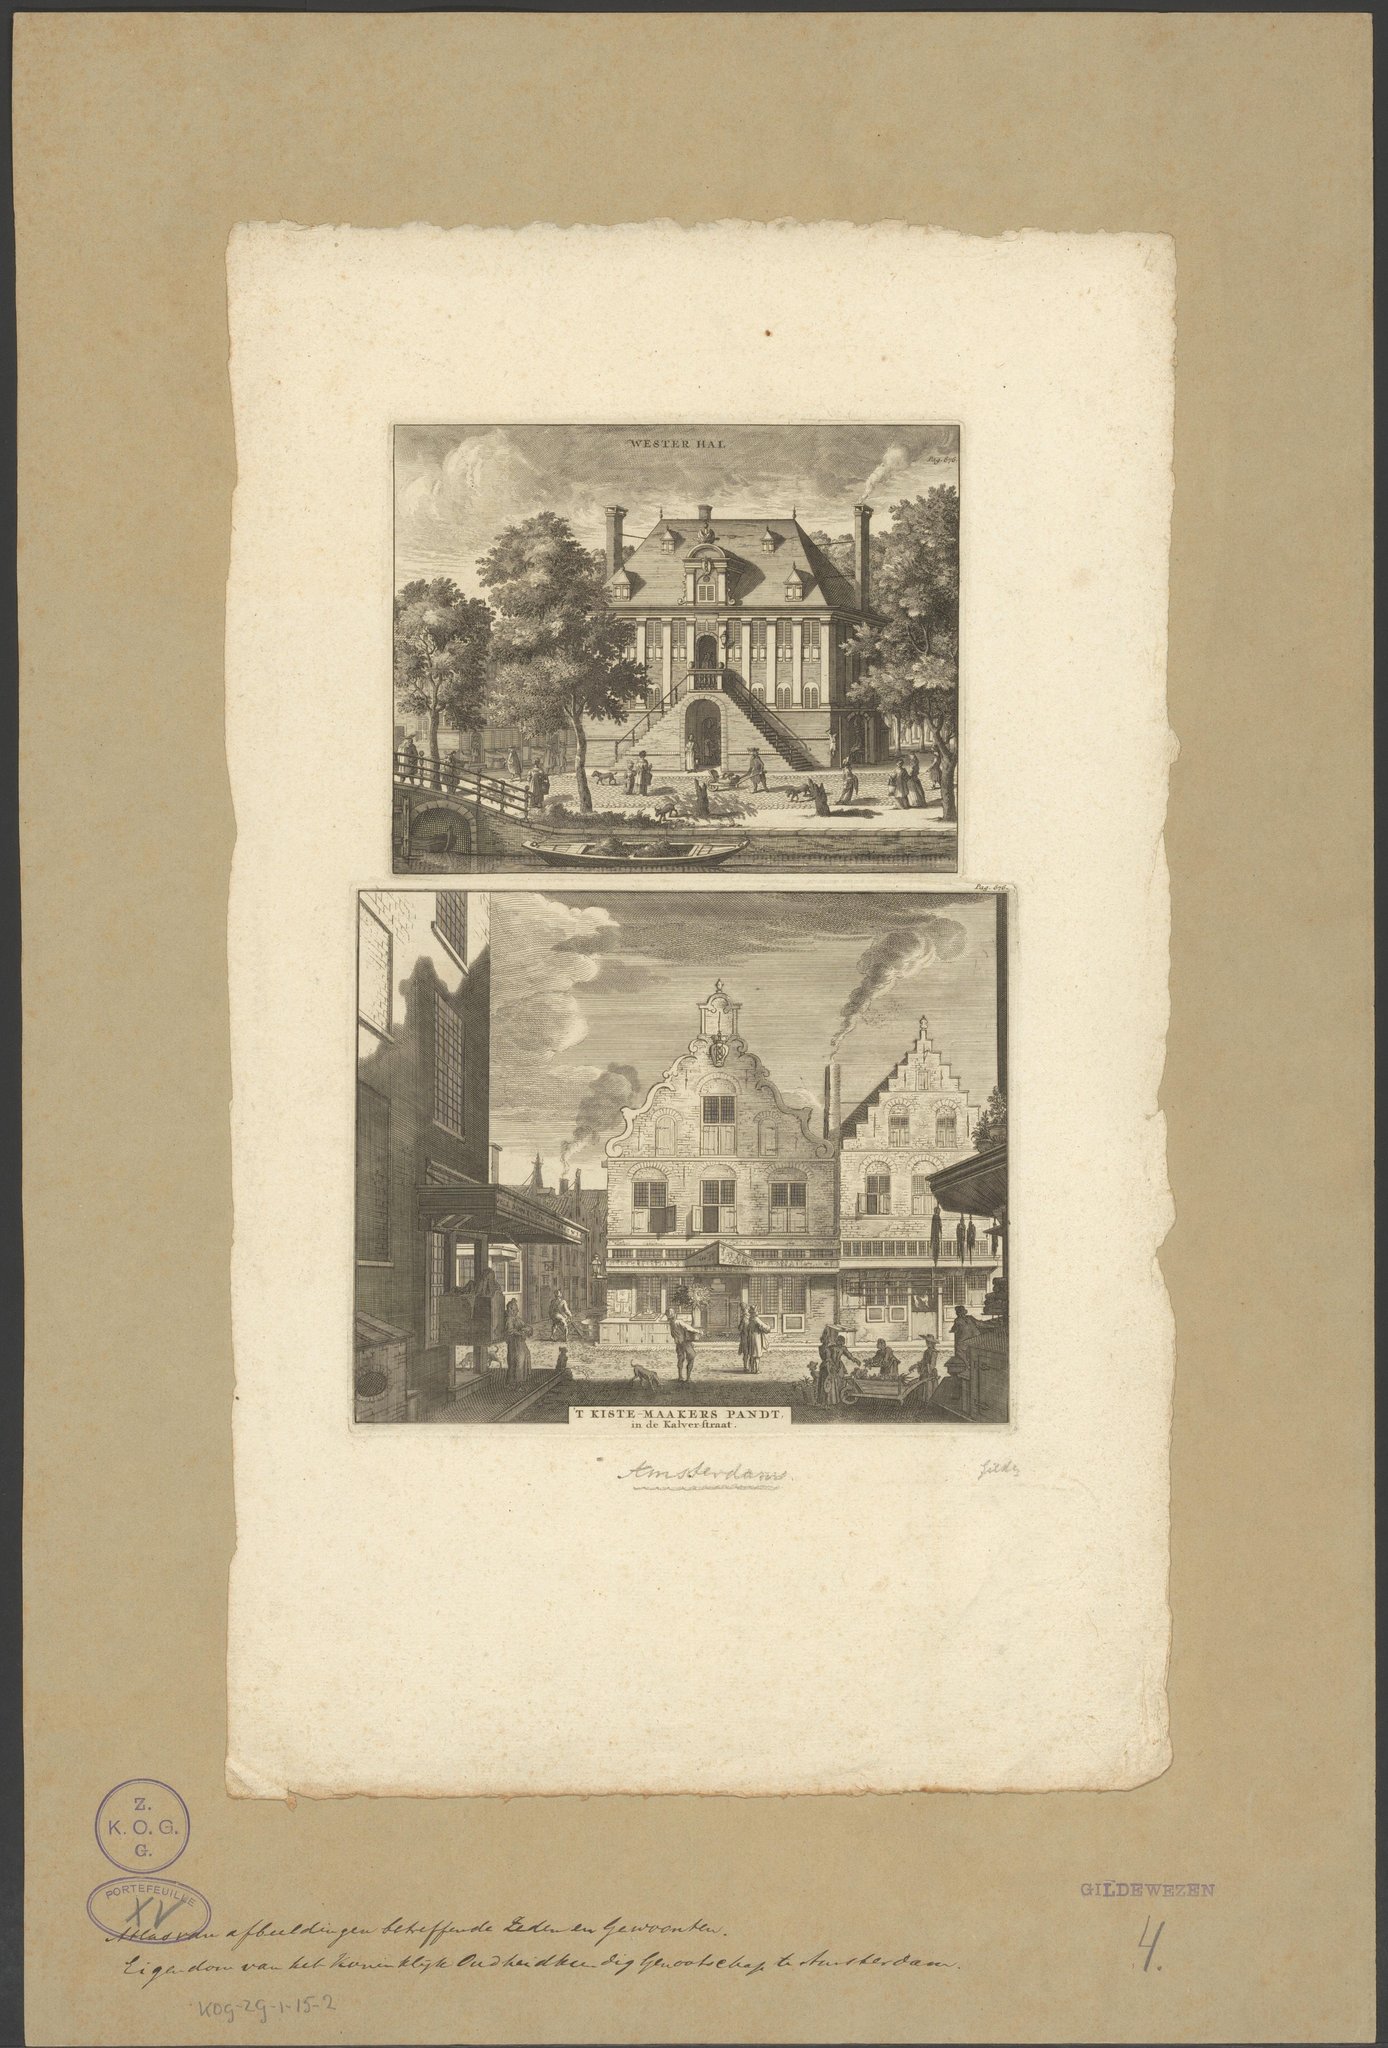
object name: print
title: Wester Hal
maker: Anonymous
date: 1726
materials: paper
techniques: engraving, etching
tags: bridge in city across river, canal, etc. (+ city(-scape) with figures, staffage), guildhall, street, market-hall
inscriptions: collector's mark: Lugt 1641, stamp, stamp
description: Prent waarschijnlijk uit: Commelin, Caspar. Beschryvinge van Amsterdam, zynde een naukeurige verhandelinge van desselfs eerste oorspronk uyt (…). 2 dln. 2de druk. Amsterdam: Andries van Damme et al., dl. 2, 1726, na p. 676. In tegenstelling tot de meeste prenten uit deze publicatie komt deze prent niet in huidige of eerdere staat voor in de uitgaves van 1693 en 1694.